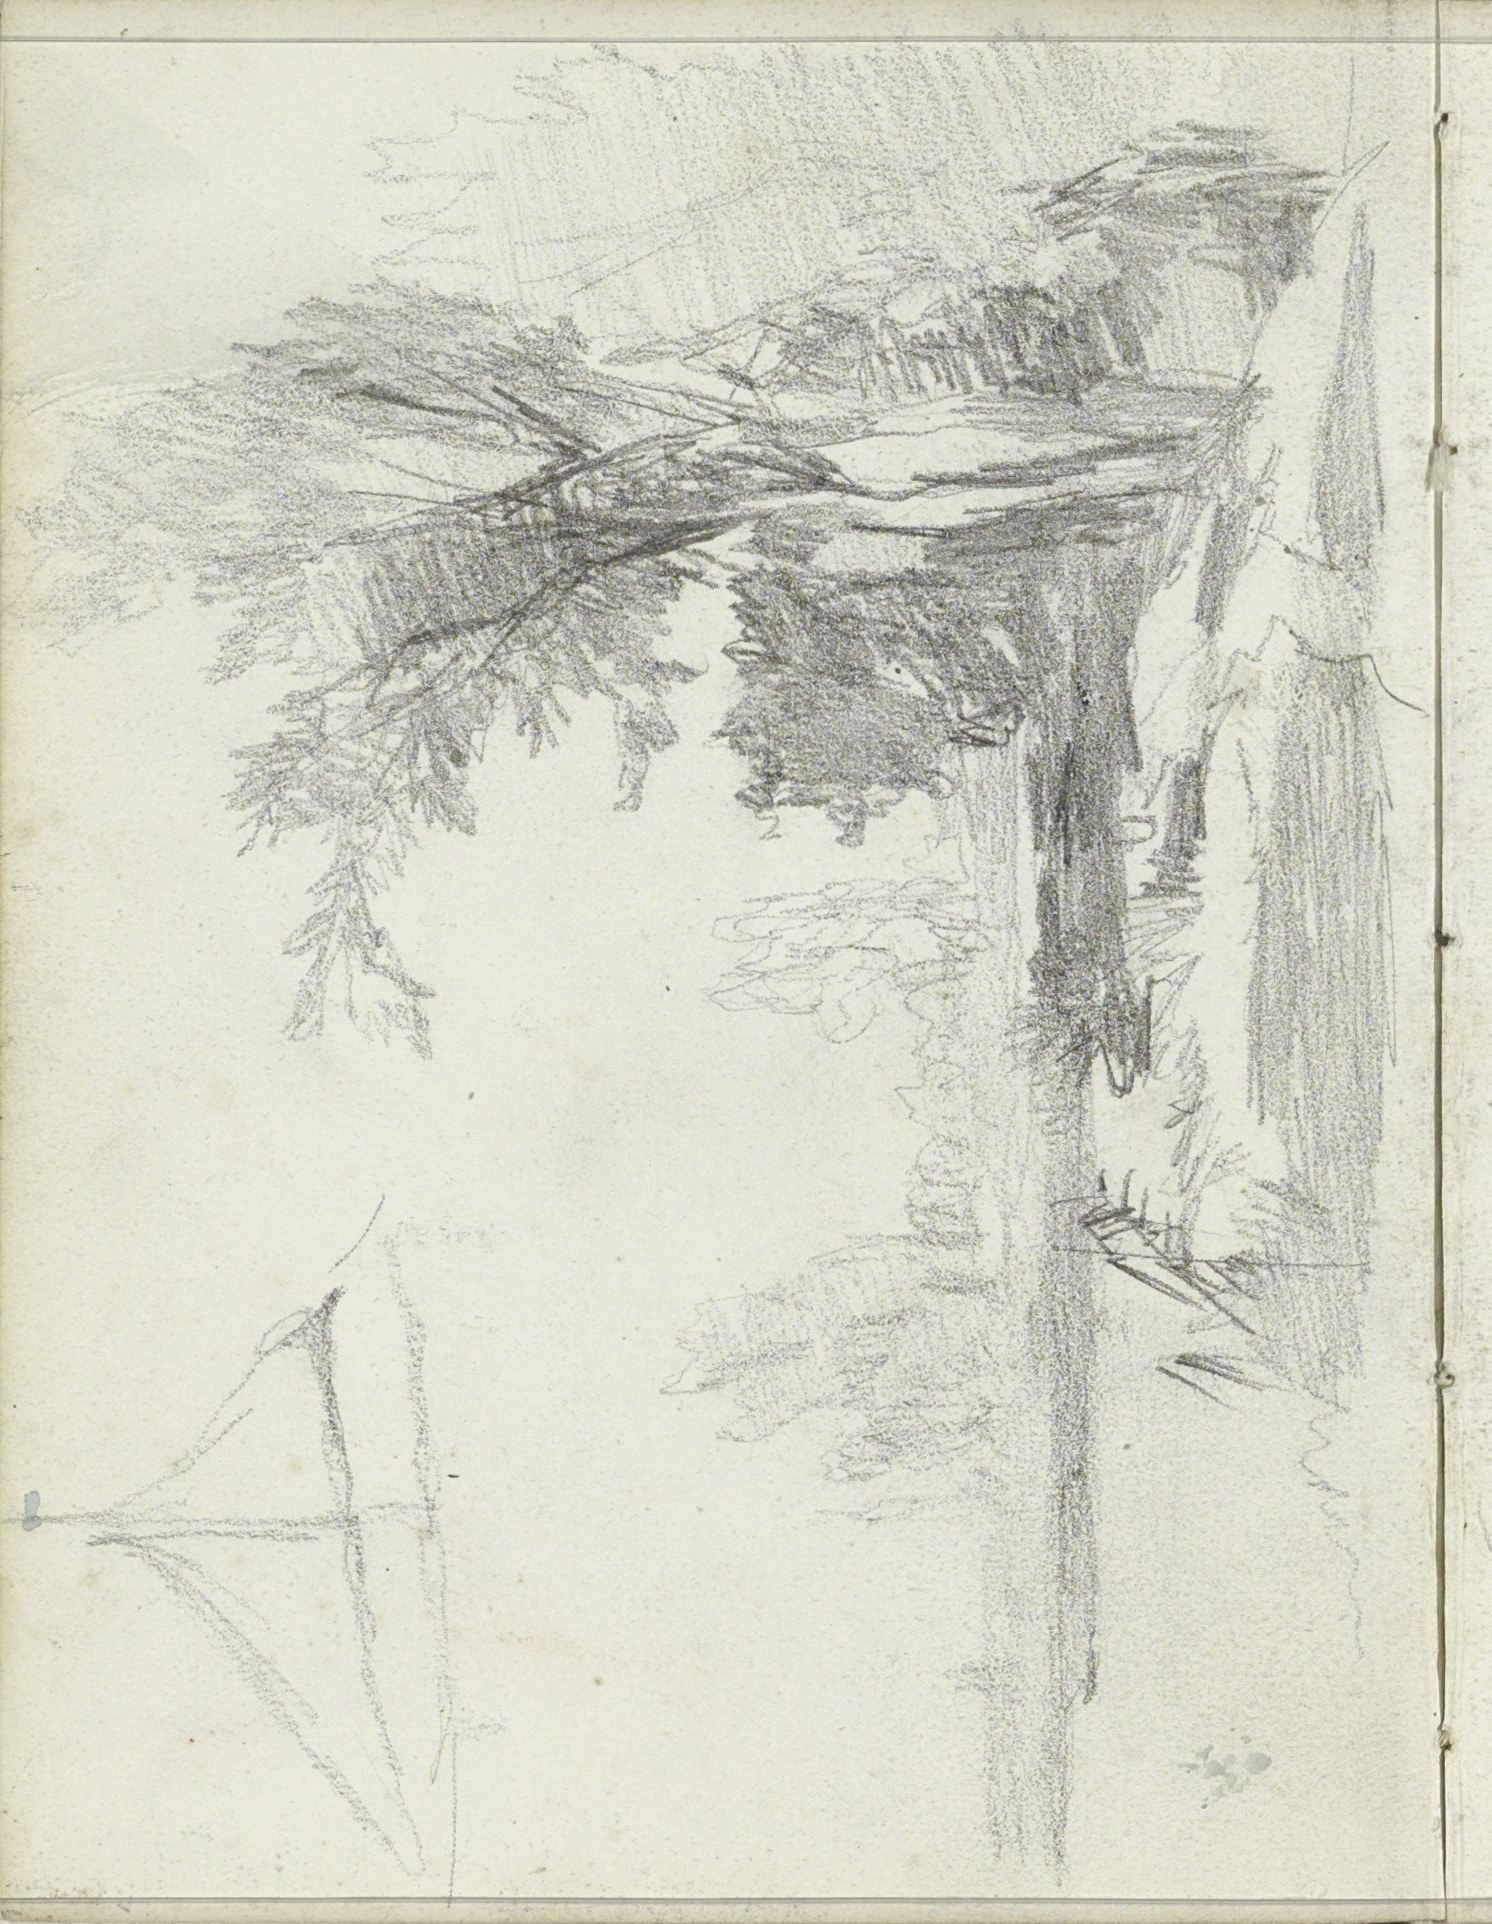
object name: sketchbook leaf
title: Bomen aan een waterkant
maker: johan hendrik weissenbruch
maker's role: draughtsman, painter, print maker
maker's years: 1824-1903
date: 1834-1903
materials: paper, pencil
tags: sailing-ship, sailing-boat, landscapes with waters, waterscapes, seascapes (in the temperate zone)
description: Tevens een studie van een zeilboot. Blad 4 verso uit een schetsboek met 34 bladen.